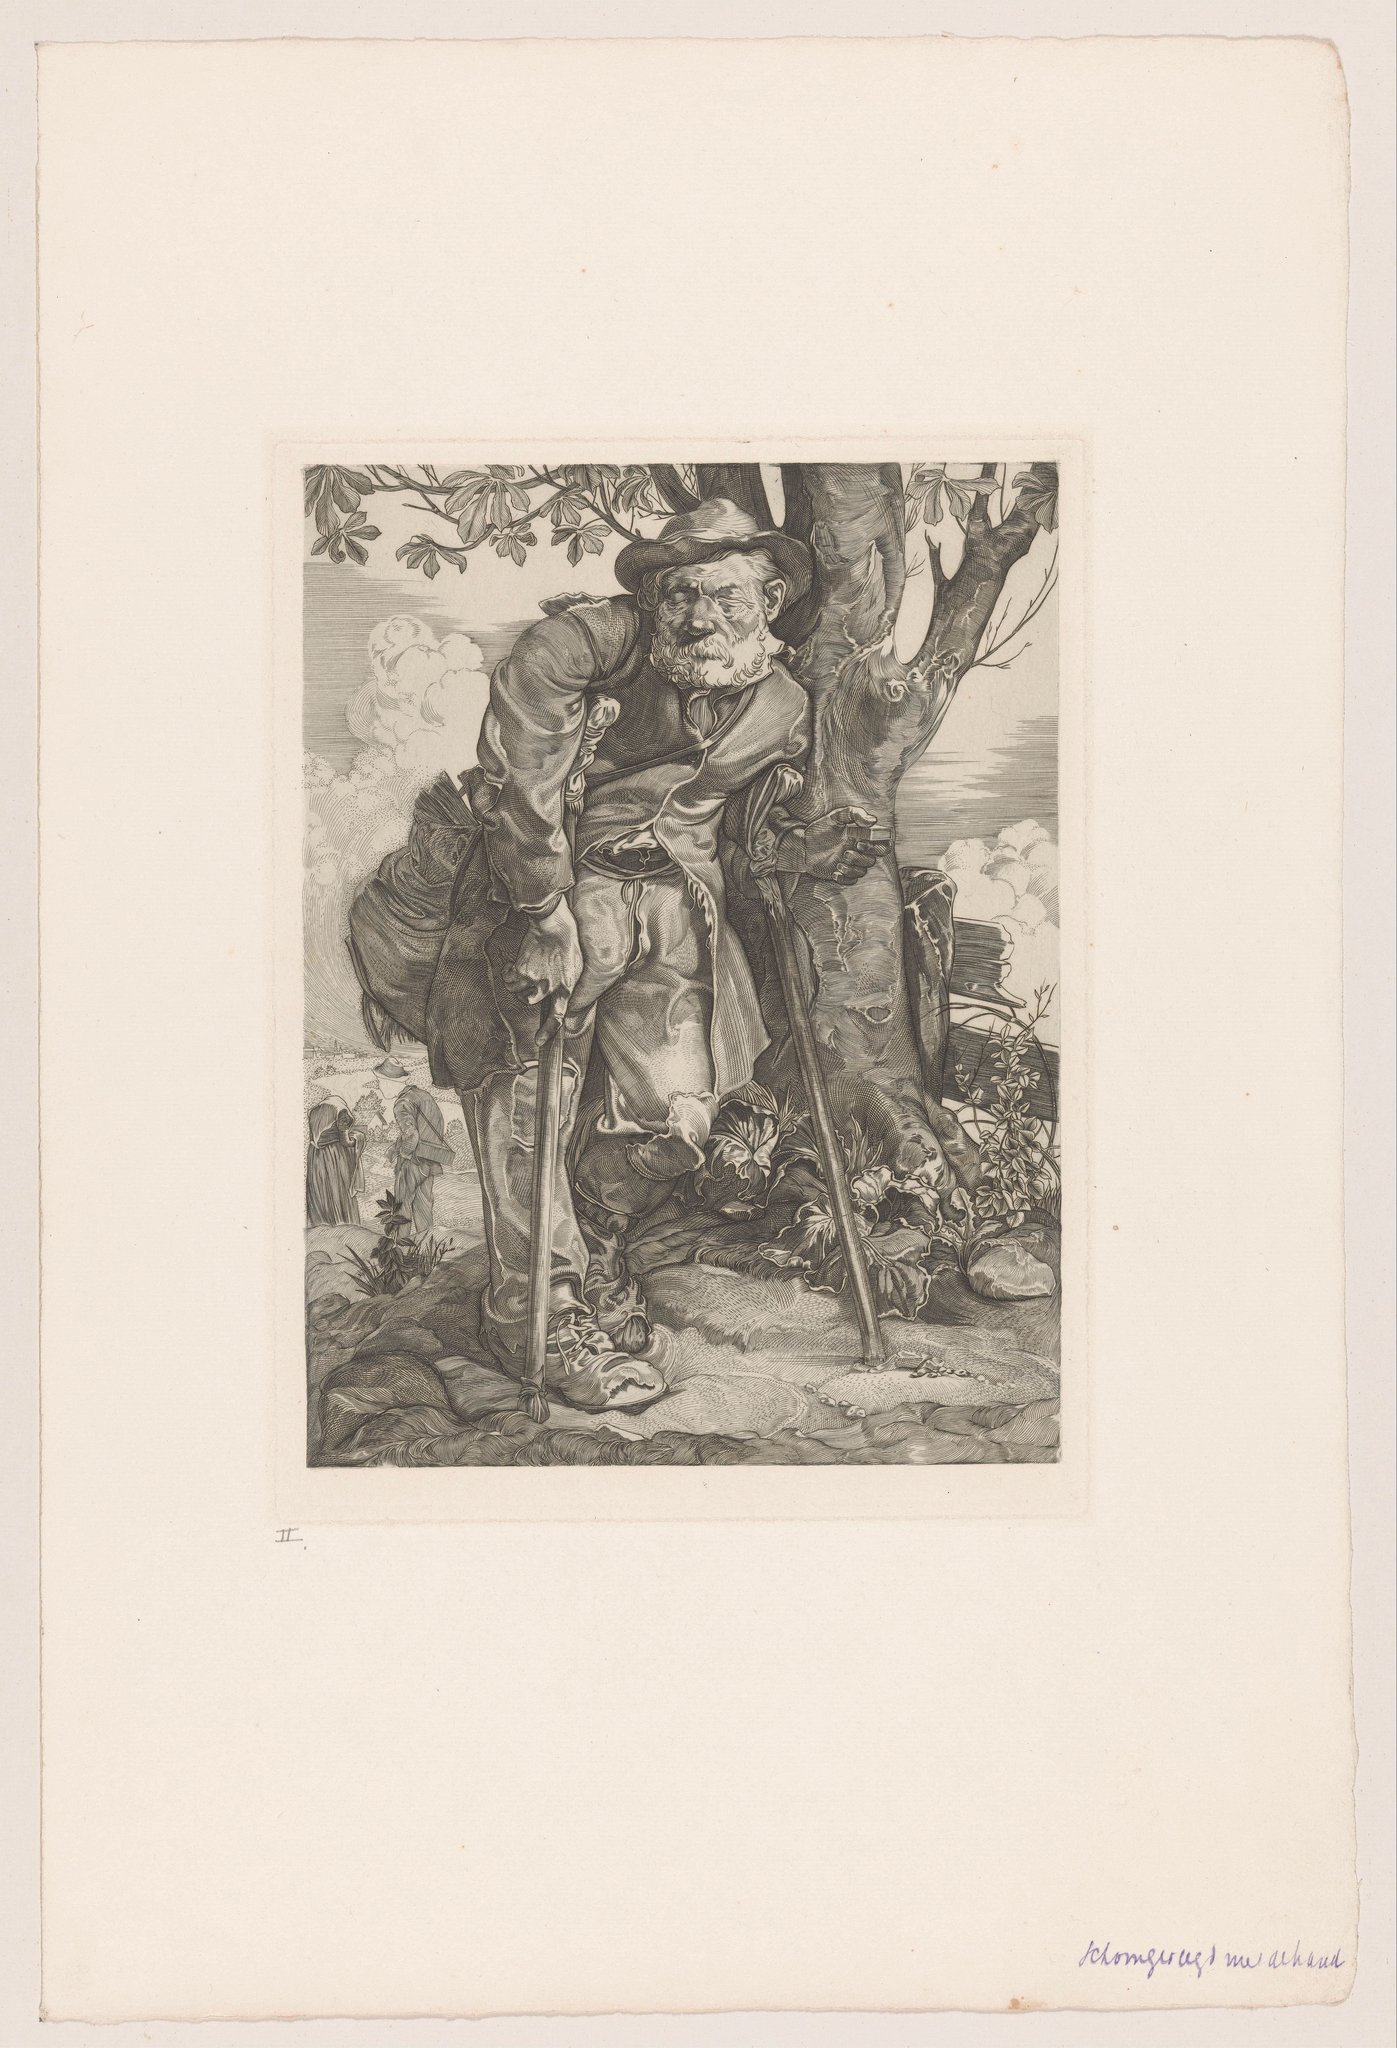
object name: print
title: Landlooper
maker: johannes josephus aarts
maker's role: draughtsman, print maker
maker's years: 1871-1934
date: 1907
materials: paper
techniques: engraving, intaglio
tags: crutches, beggar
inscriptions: collector's mark: Lugt 2166, annotation: ‘schoongeveegd met de hand’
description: Een bebaarde man met hoed, gekleed in beschadigde, deels herstelde kleren, lopend met twee krukken. In zijn linkerhand een klein, rechthoekig voorwerp. Linksachter hem een man en een vrouw, rechtsachter hem een boom.